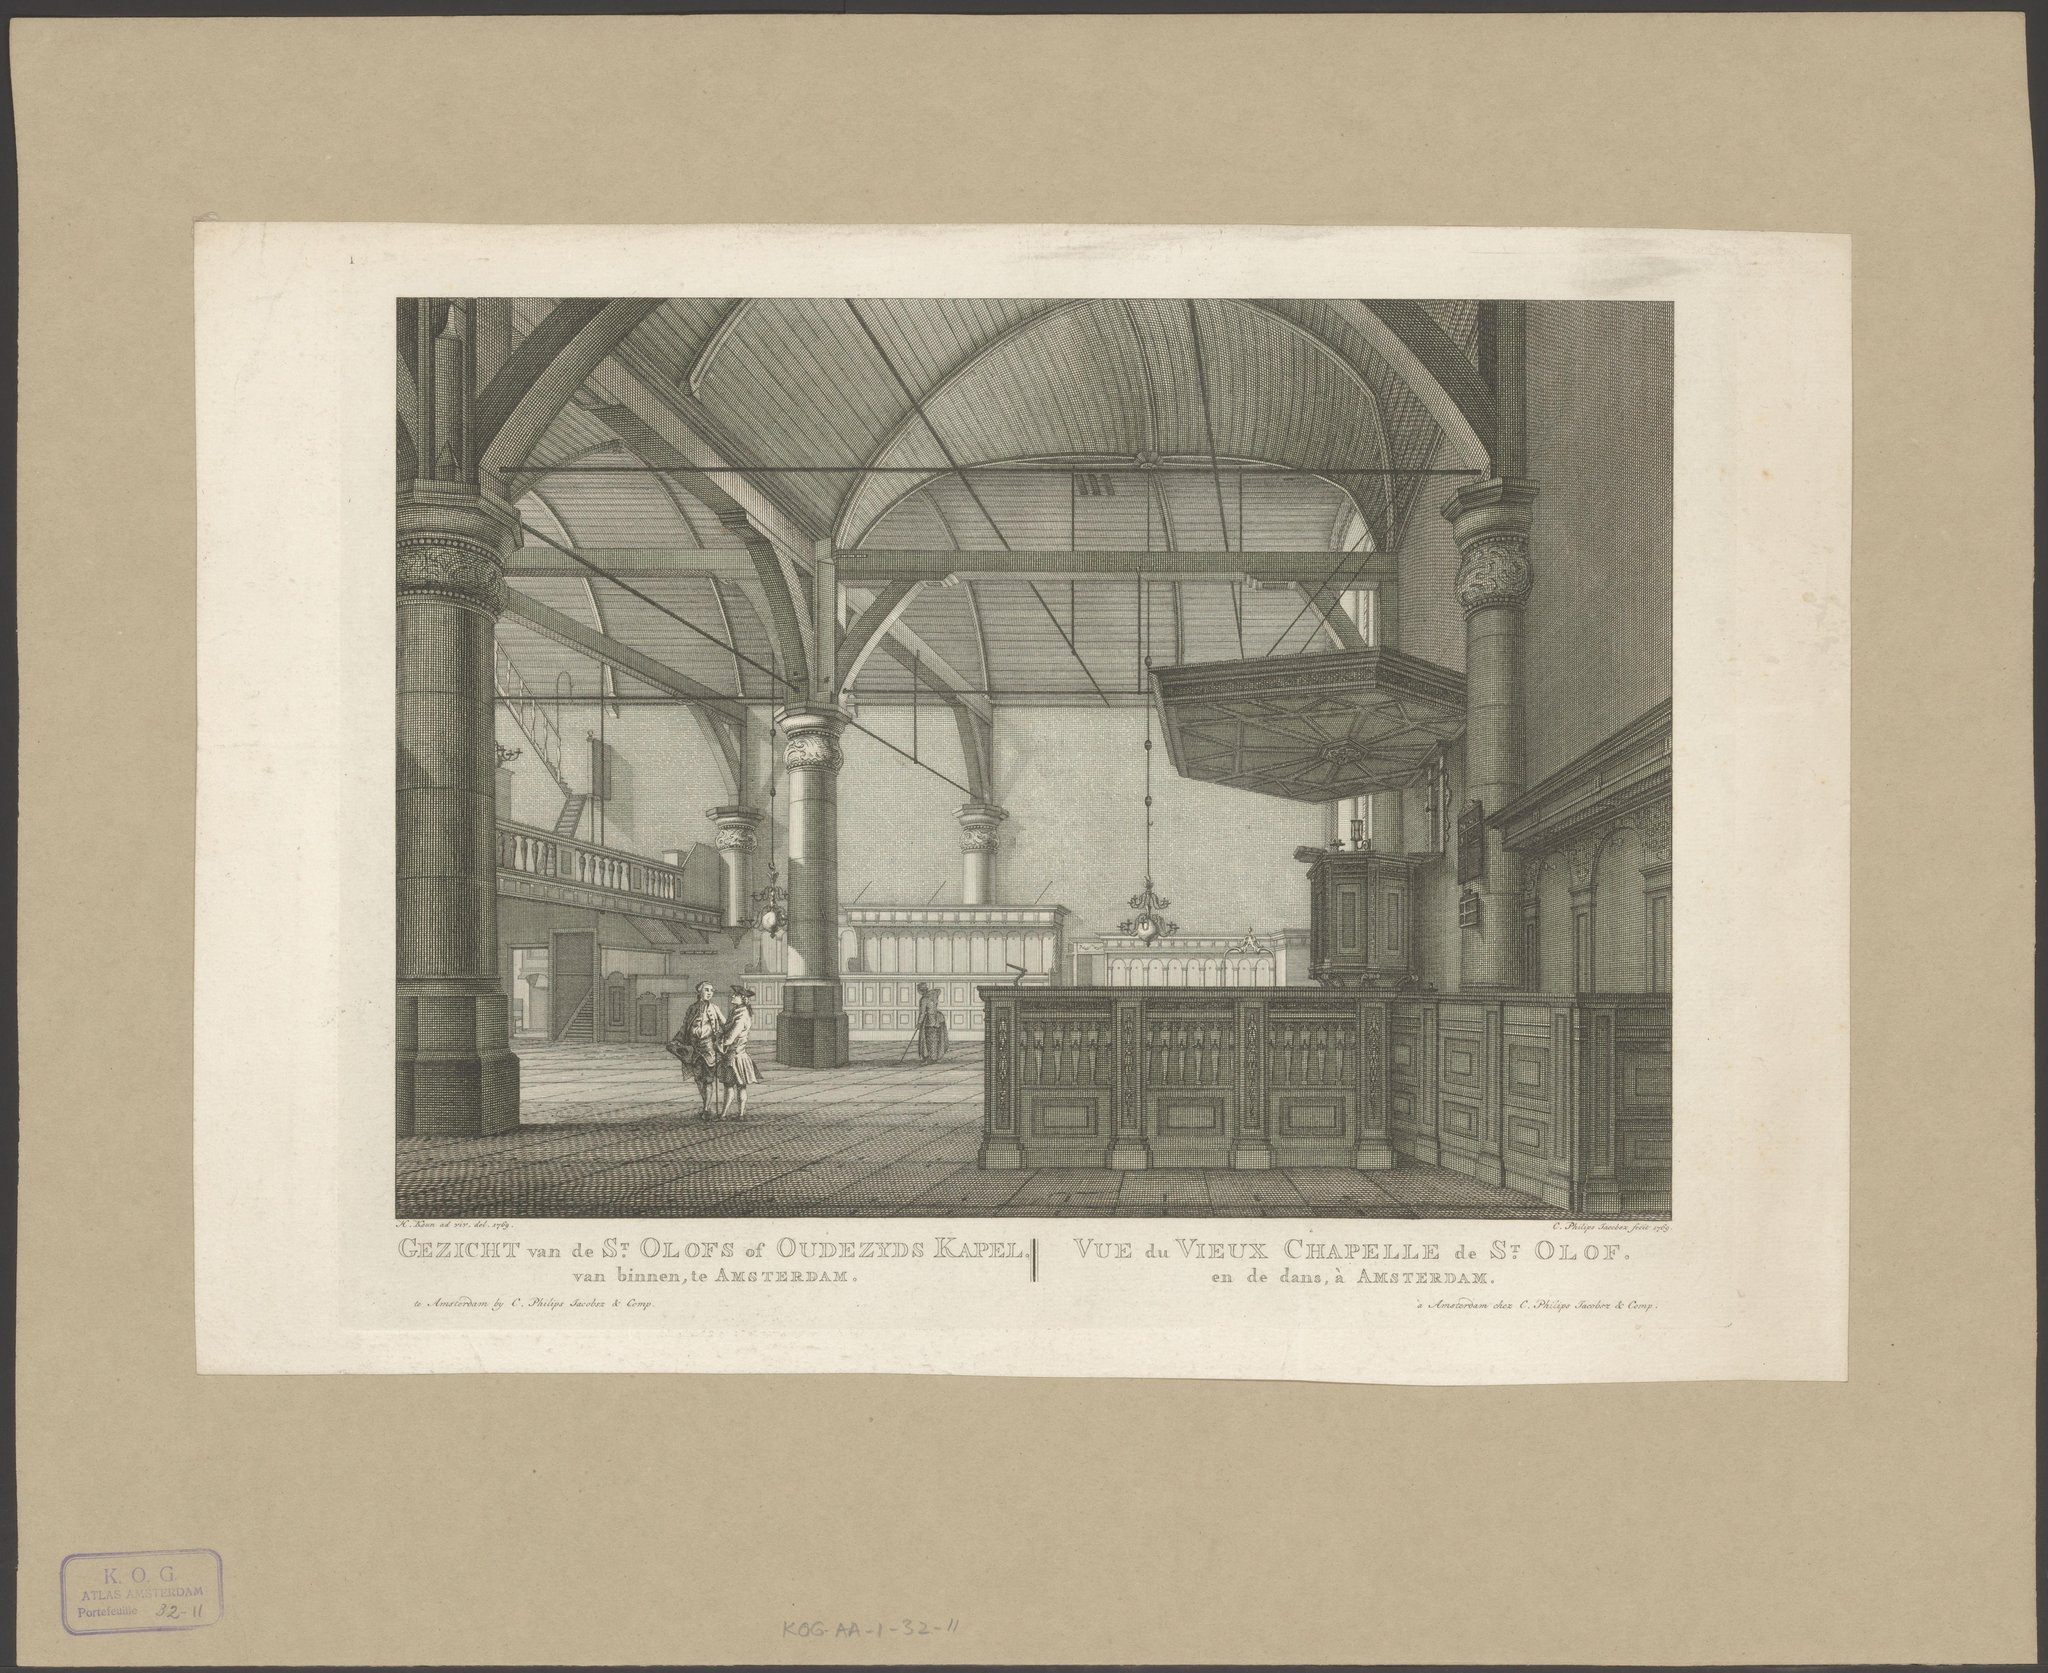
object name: print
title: Interieur van de Sint Olofskapel te Amsterdam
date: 1769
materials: paper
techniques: engraving, etching, letterpress printing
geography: amsterdam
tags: interior of church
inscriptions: collector's mark: ‘32-11’ Lugt 1641b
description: Onderwerpsrubriek binnen de Atlas Amsterdam: Kerkwezen: Hervormde Gemeente: Oudezijds Kapel.